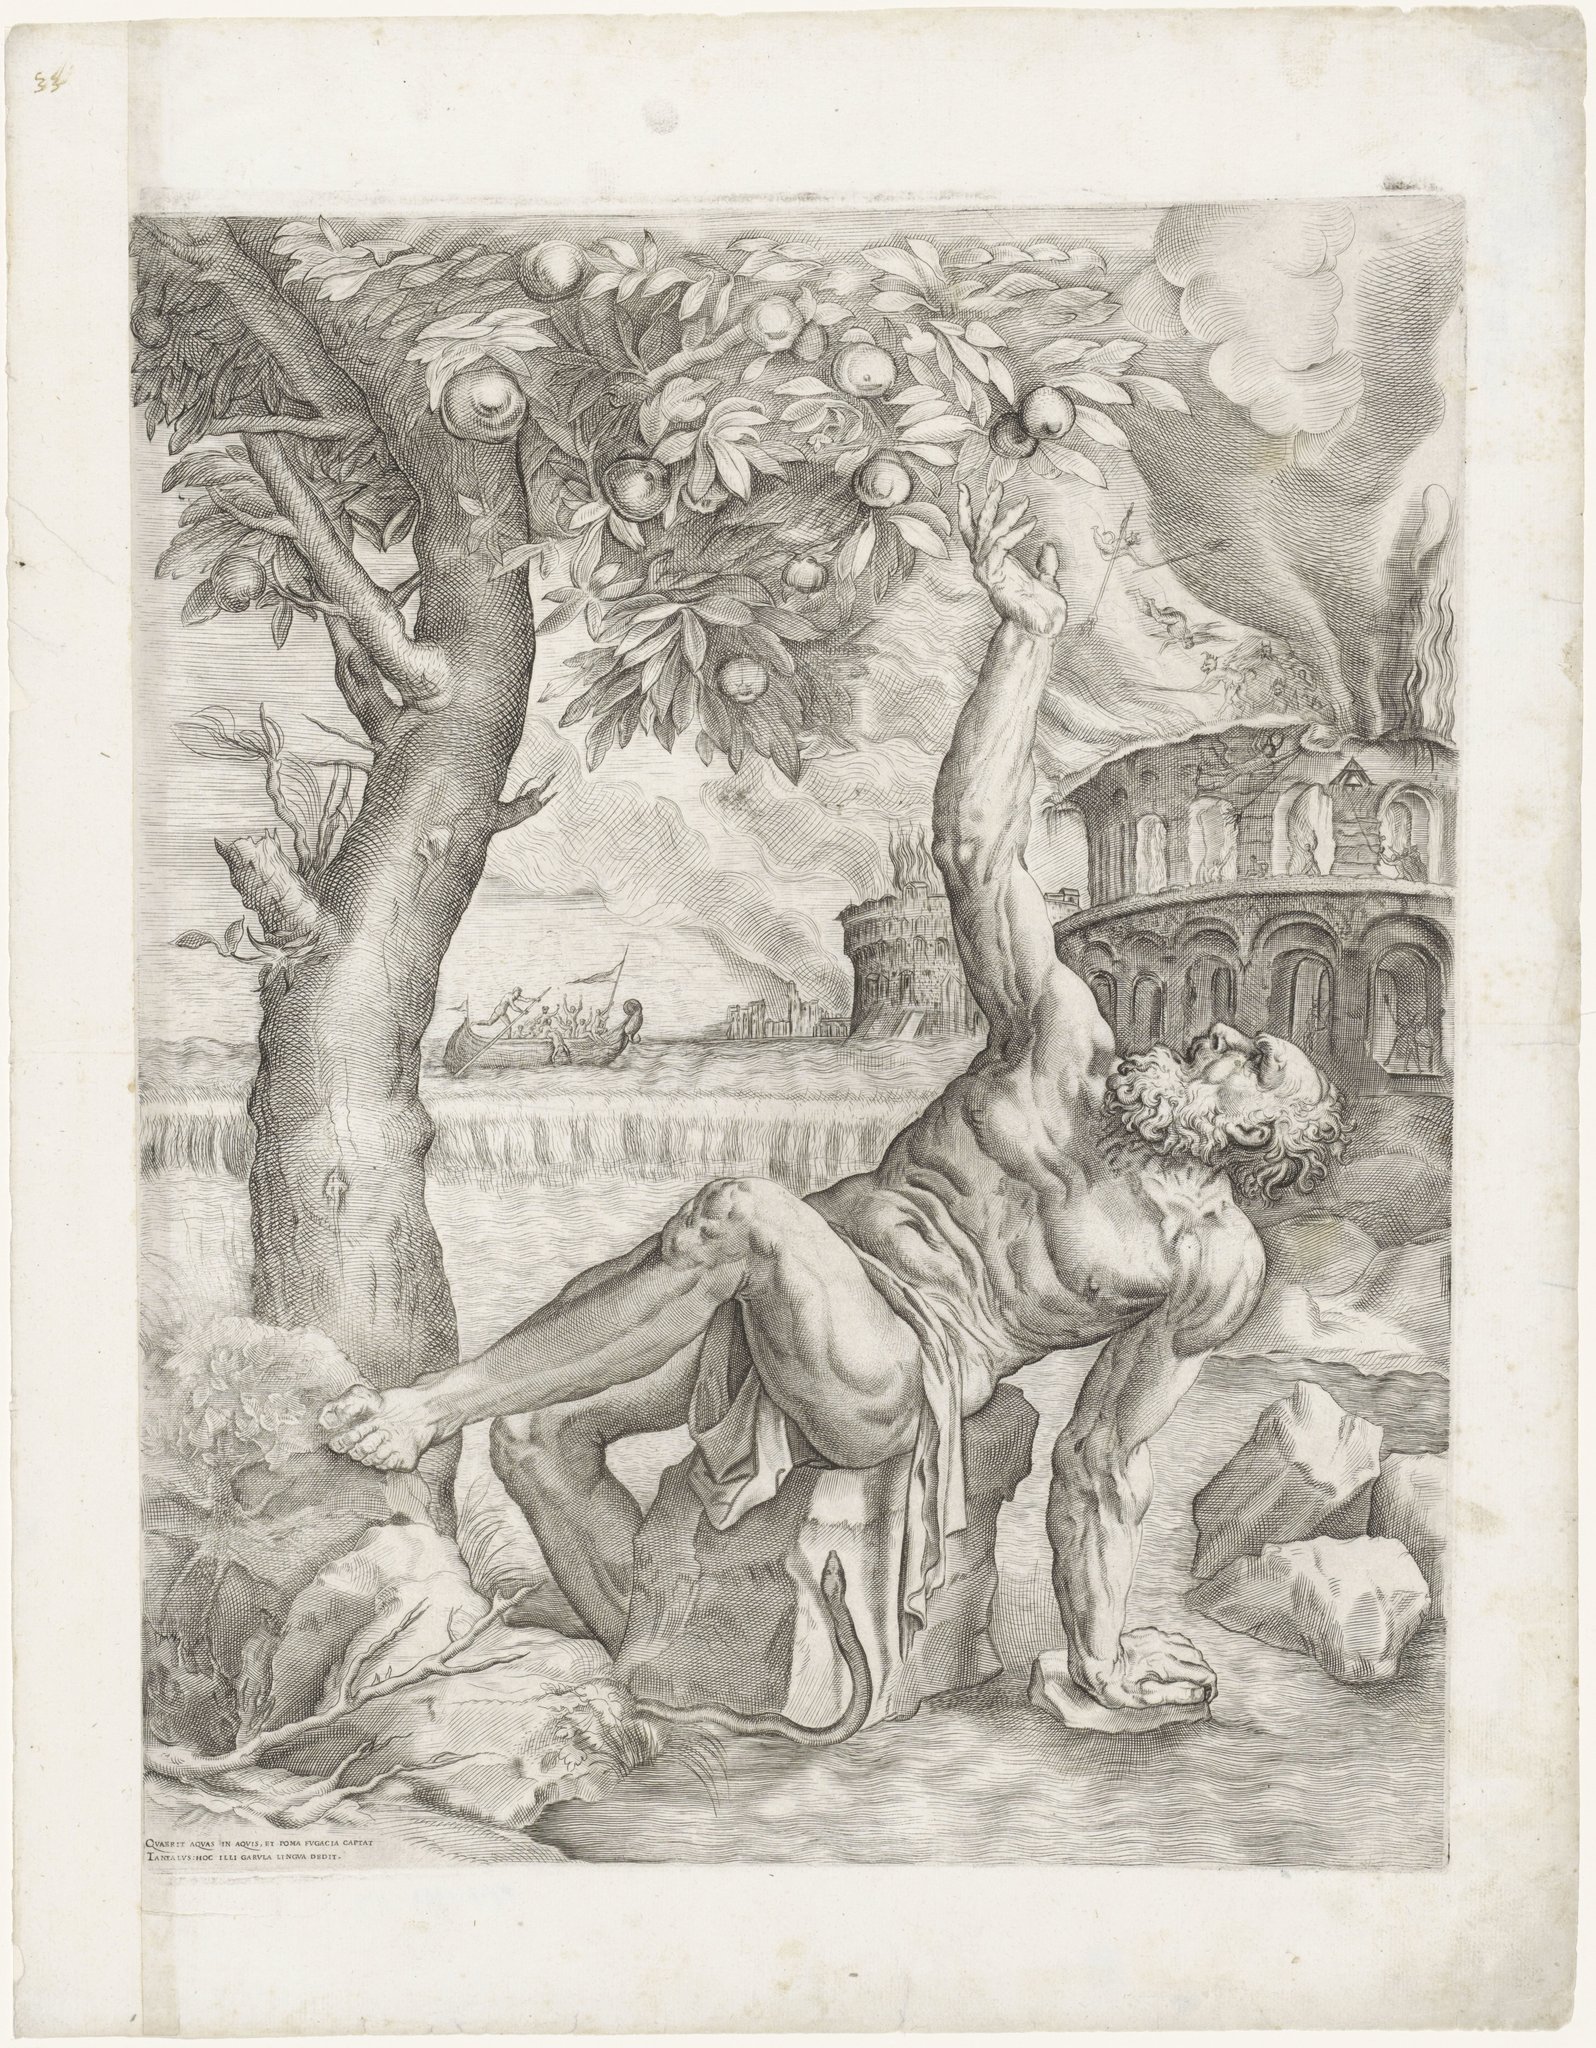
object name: album leaf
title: Tantalus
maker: giulio sanuto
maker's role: print maker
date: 1565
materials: paper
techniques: engraving, etching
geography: italy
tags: (story of) tantalus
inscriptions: number: ‘33’, watermark, collector's mark: Lugt 2228, collector's mark: Lugt 2760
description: This magnificent print by the Venetian artist Sanuto reproduces a lost painting by Titian that was commissioned by Mary of Hungary. Tantalus was subject to eternal punishment by the gods for having murdered his own son. The so-called torment of Tantalus is a state in which what one desires is always nearby and yet always remains tantalizingly out of reach. When Tantalus reaches for the fruit in the tree, the branches grow; and when he tries to drink the water it recedes.